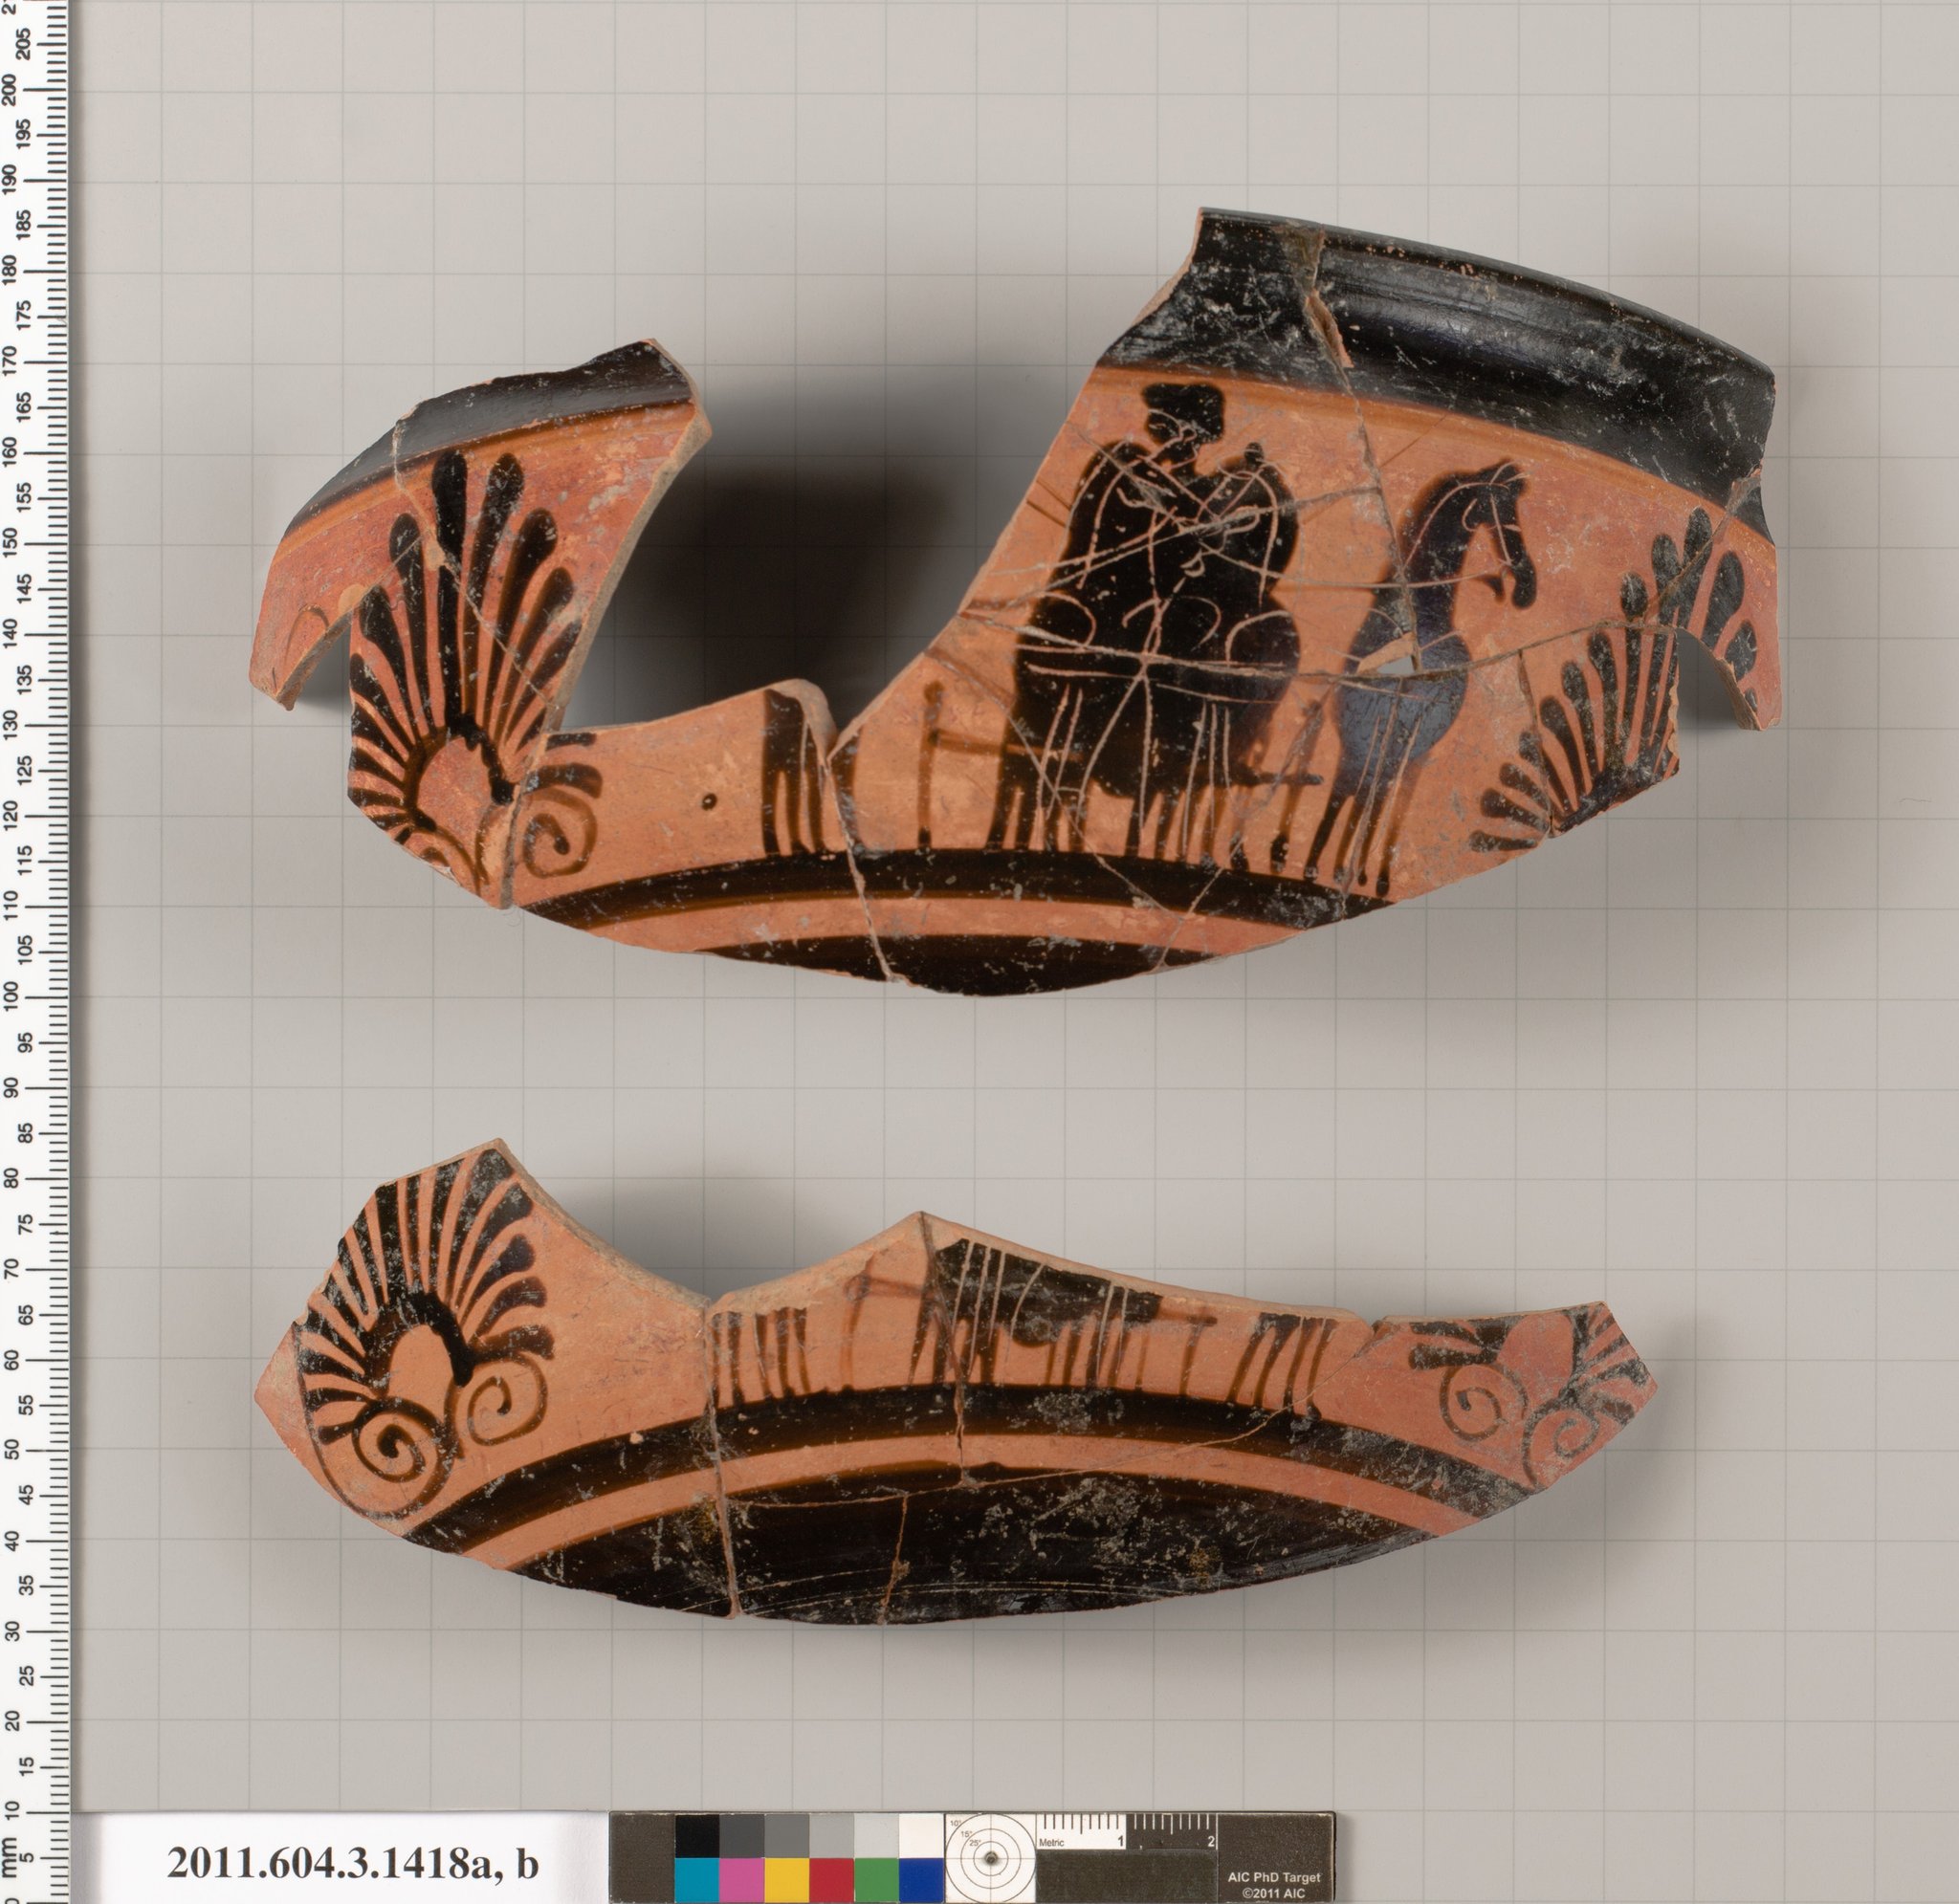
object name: skyphos fragment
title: Terracotta fragments of a skyphos (deep drinking cup)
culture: greek, attic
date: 500-468 BCE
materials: terracotta